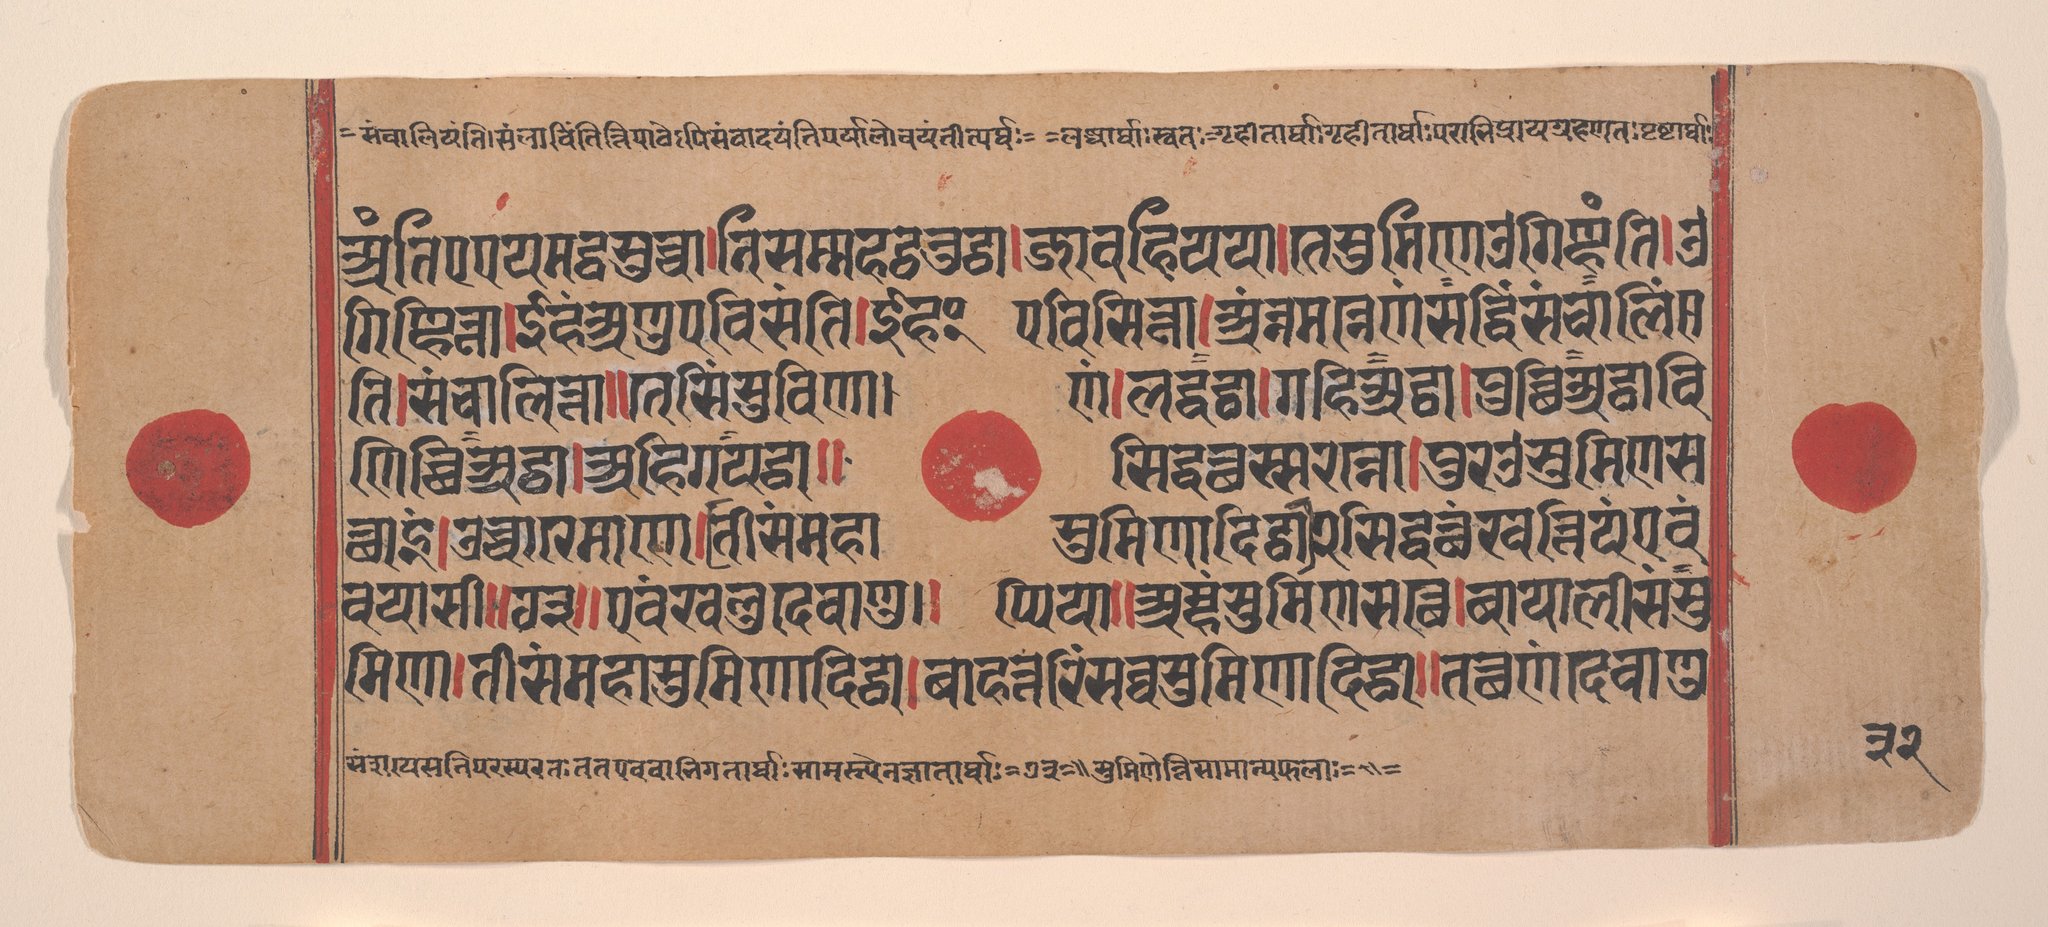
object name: folio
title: Page from a Dispersed Kalpa Sutra (Jain Book of Rituals)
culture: indian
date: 1401-1500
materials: gold, ink, paper, watercolor